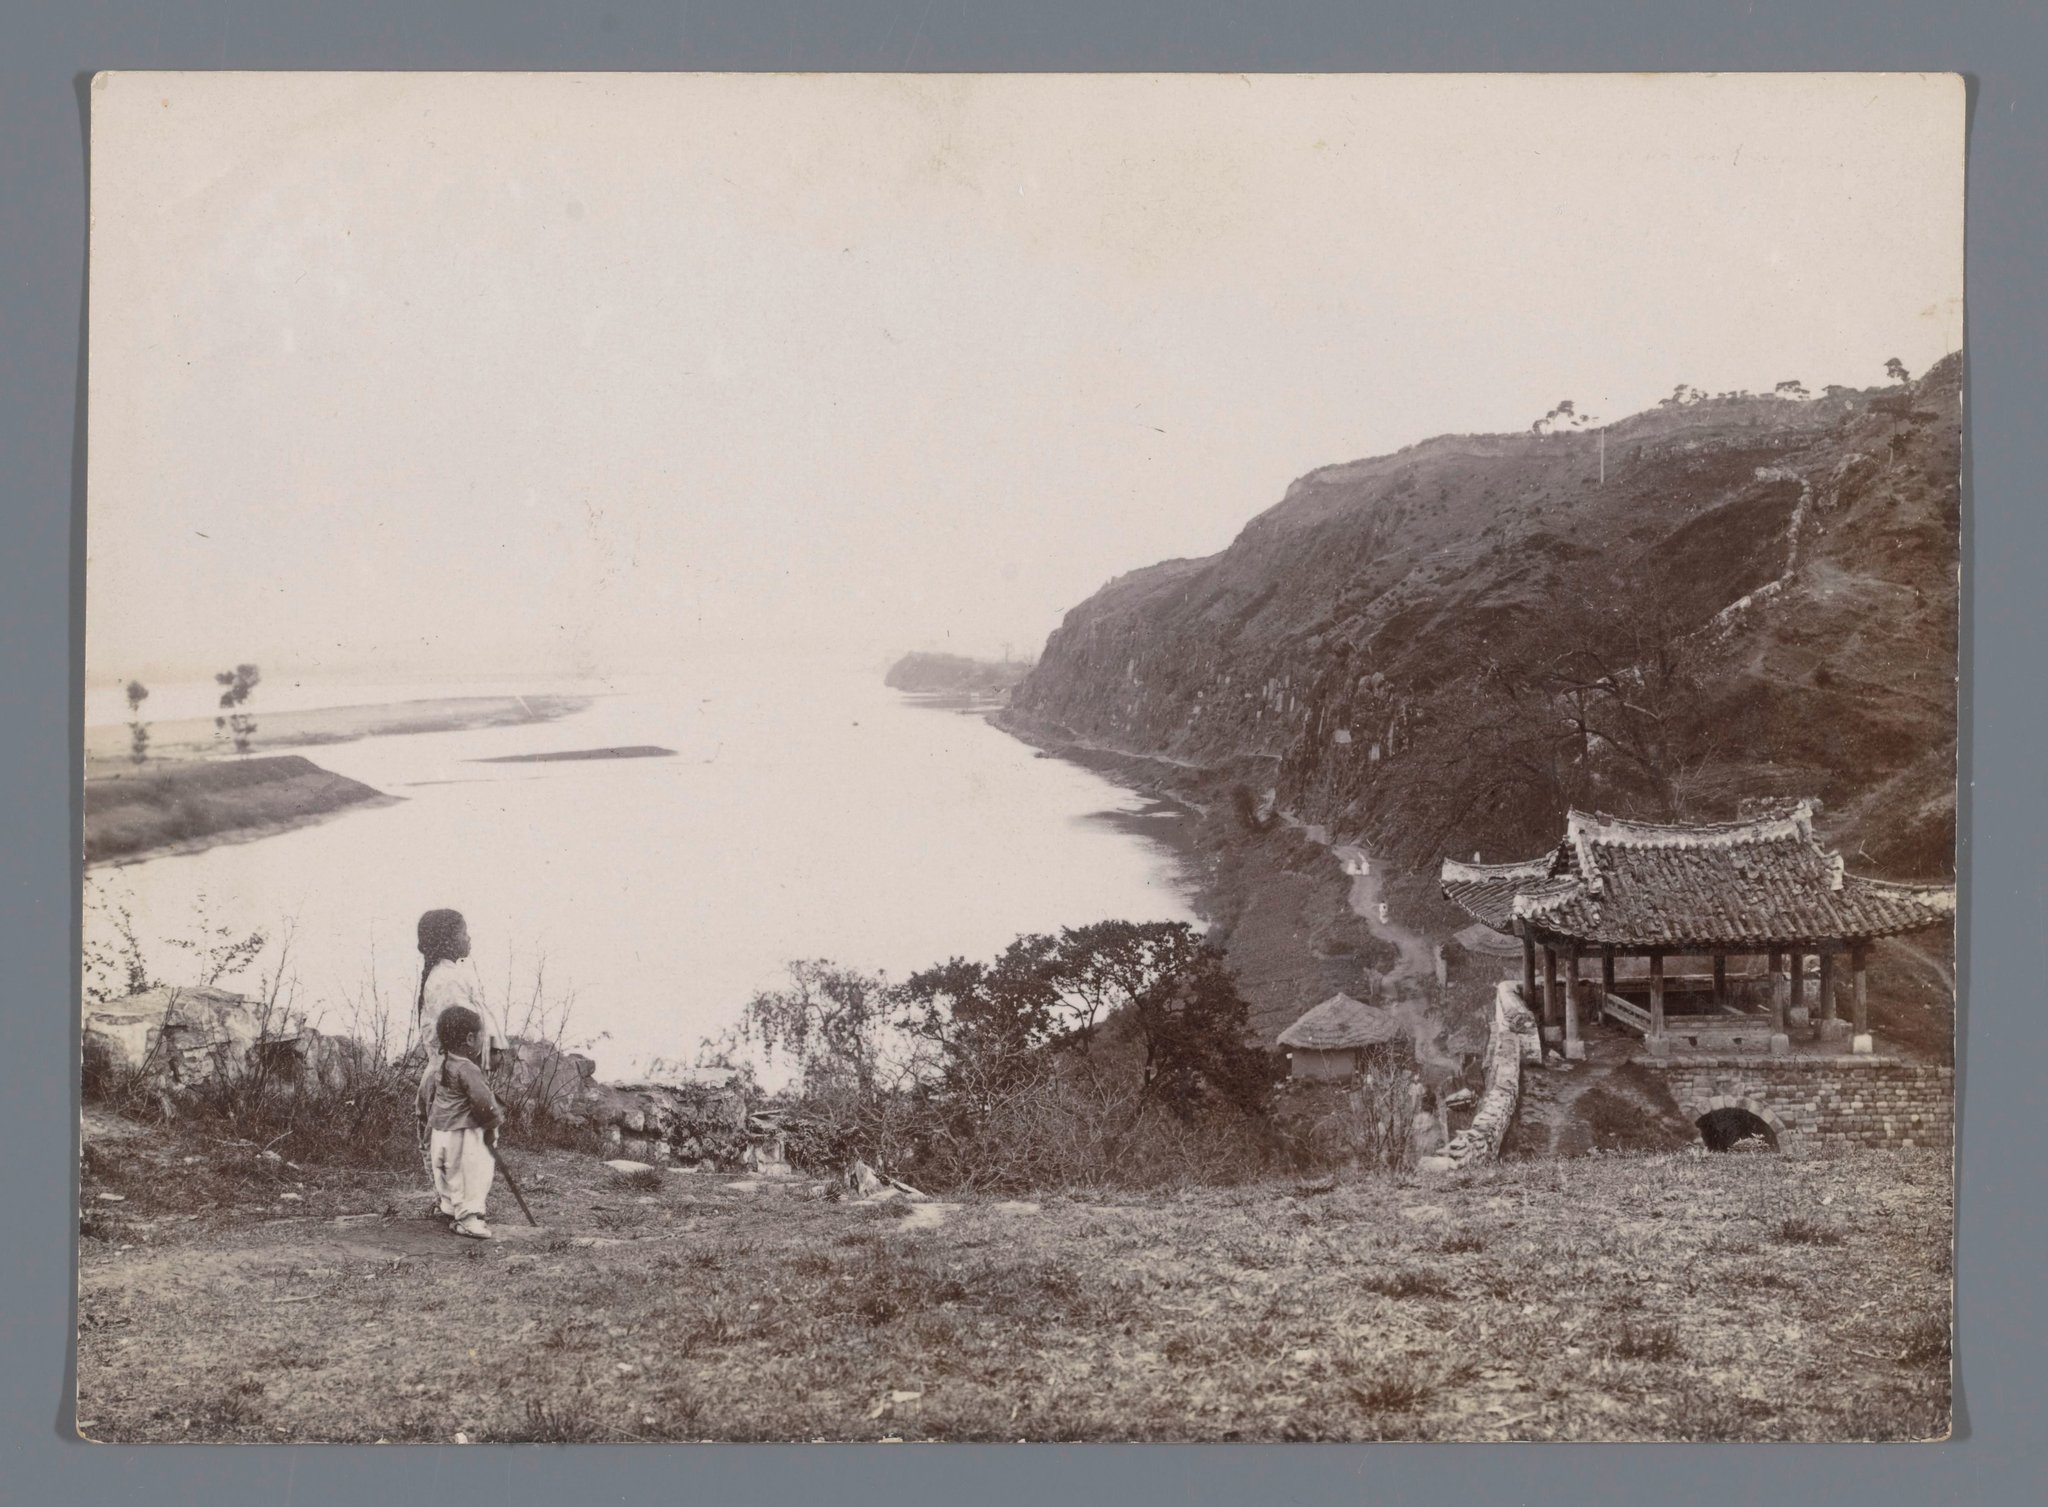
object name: photograph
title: Twee meisjes kijken uit over het water en een poort (?), Pyongyang, Korea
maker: jan adriani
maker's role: fotograaf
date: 1907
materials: paper, photographic support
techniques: gelatin silver print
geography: korea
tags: landscapes with waters, waterscapes, seascapes (in the temperate zone) (+ landscape with figures, staffage)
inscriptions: date and inscription: ‘Utrecht, le 13 Mars 1908 / Madame,’, annotation: ‘Tatong ( Pye[ng-Yang]’